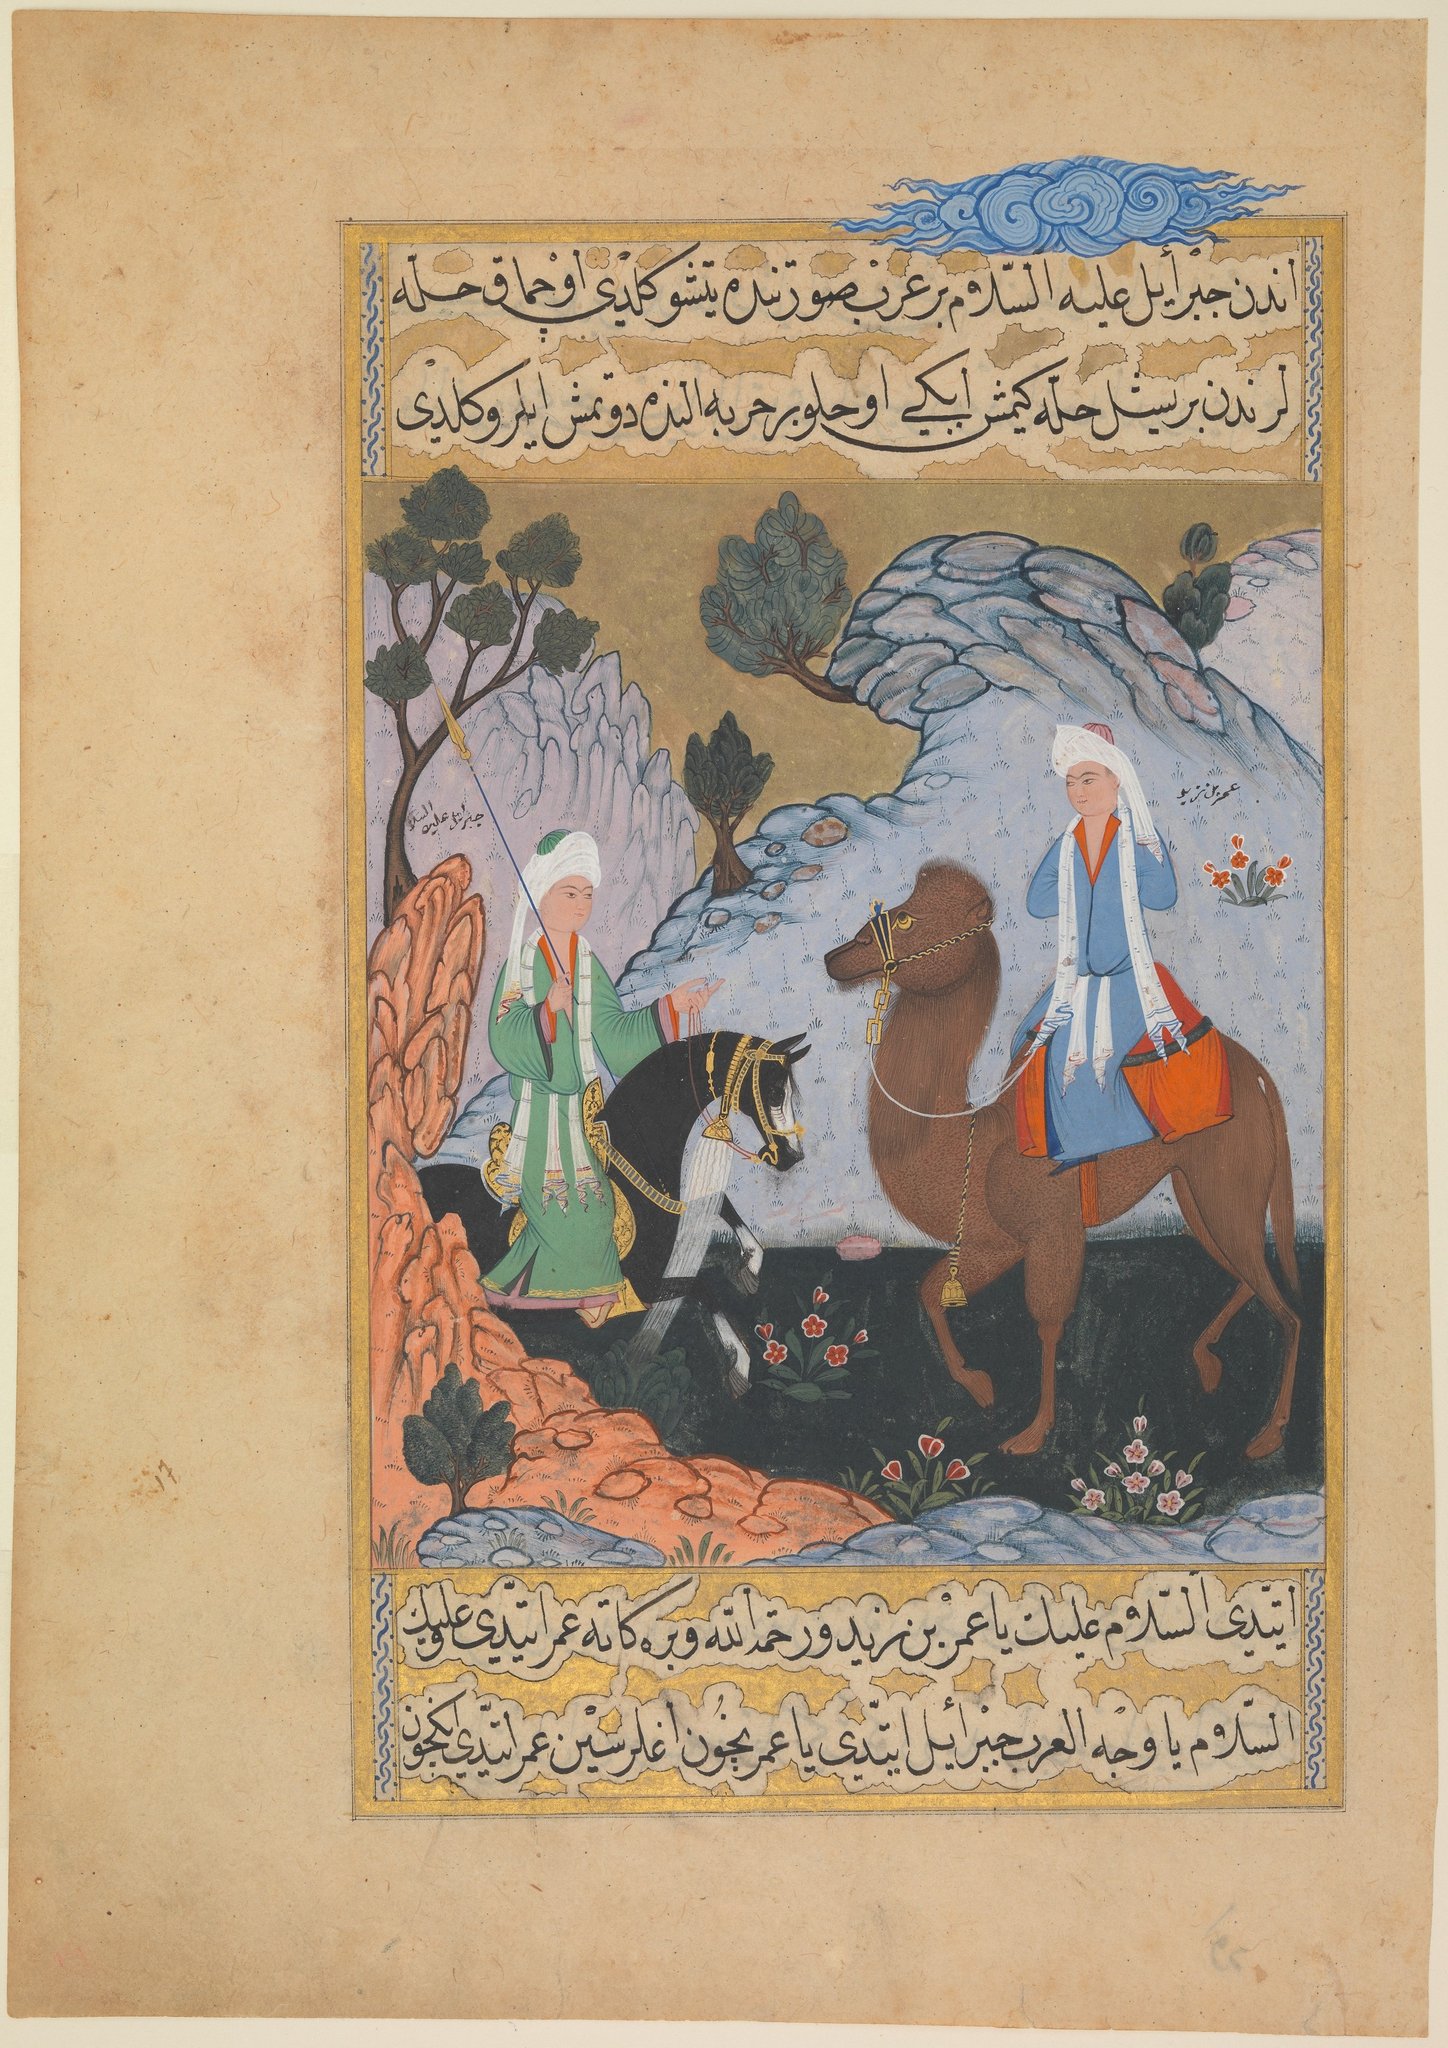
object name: folio from an illustrated manuscript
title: "The Angel Gabriel meets 'Amr ibn Zaid (the Shepherd)", Folio from a Siyer-i Nebi (the Life of the Prophet)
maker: mustafa ibn vali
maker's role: artist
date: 1595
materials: gold, ink, paper, watercolor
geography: turkey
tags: men,camels,horses,archangel gabriel